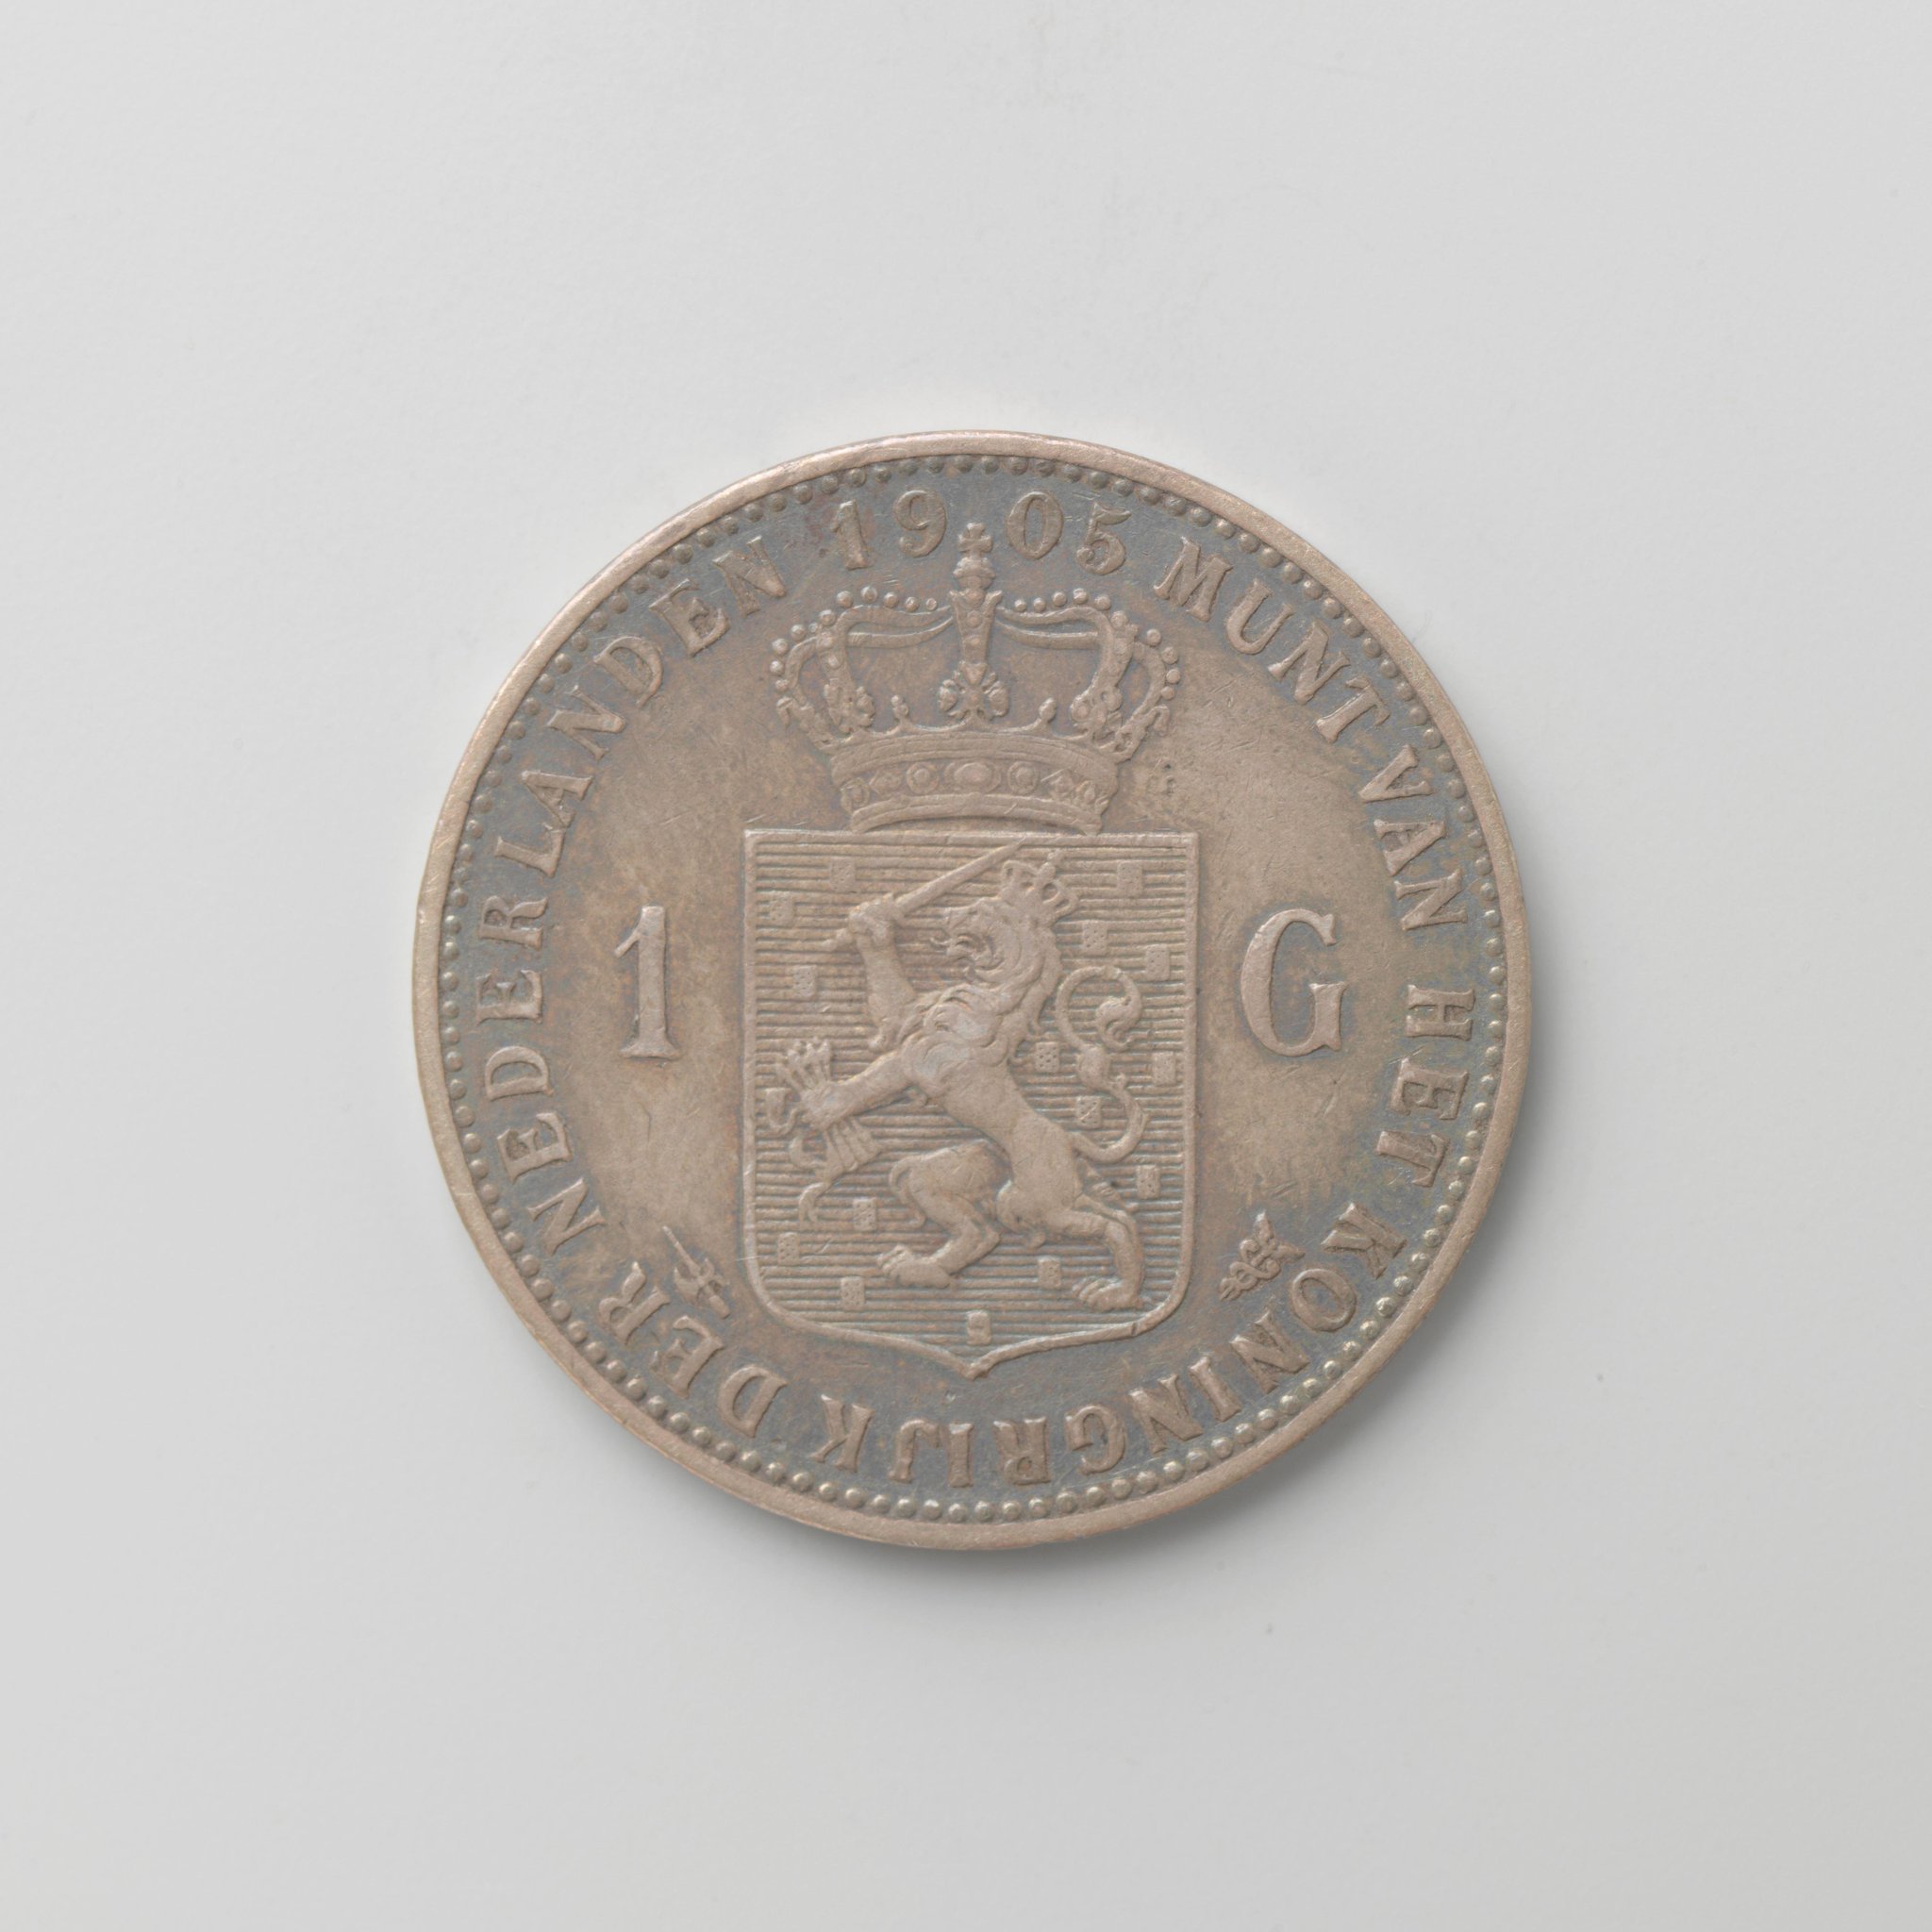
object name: coin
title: Nederlandse gulden,1905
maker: wilhelmina of the netherlands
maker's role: print maker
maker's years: 1880-1962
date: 1905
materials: silver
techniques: striking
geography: utrecht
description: Zilveren munt. Voorzijde: hoofd met diadeem naar links. Keerzijde: tussen waarde-aanduiding 1 G gekroond rijkswapenschild. Jaartal bovenaan in omschrift. Randschrift.